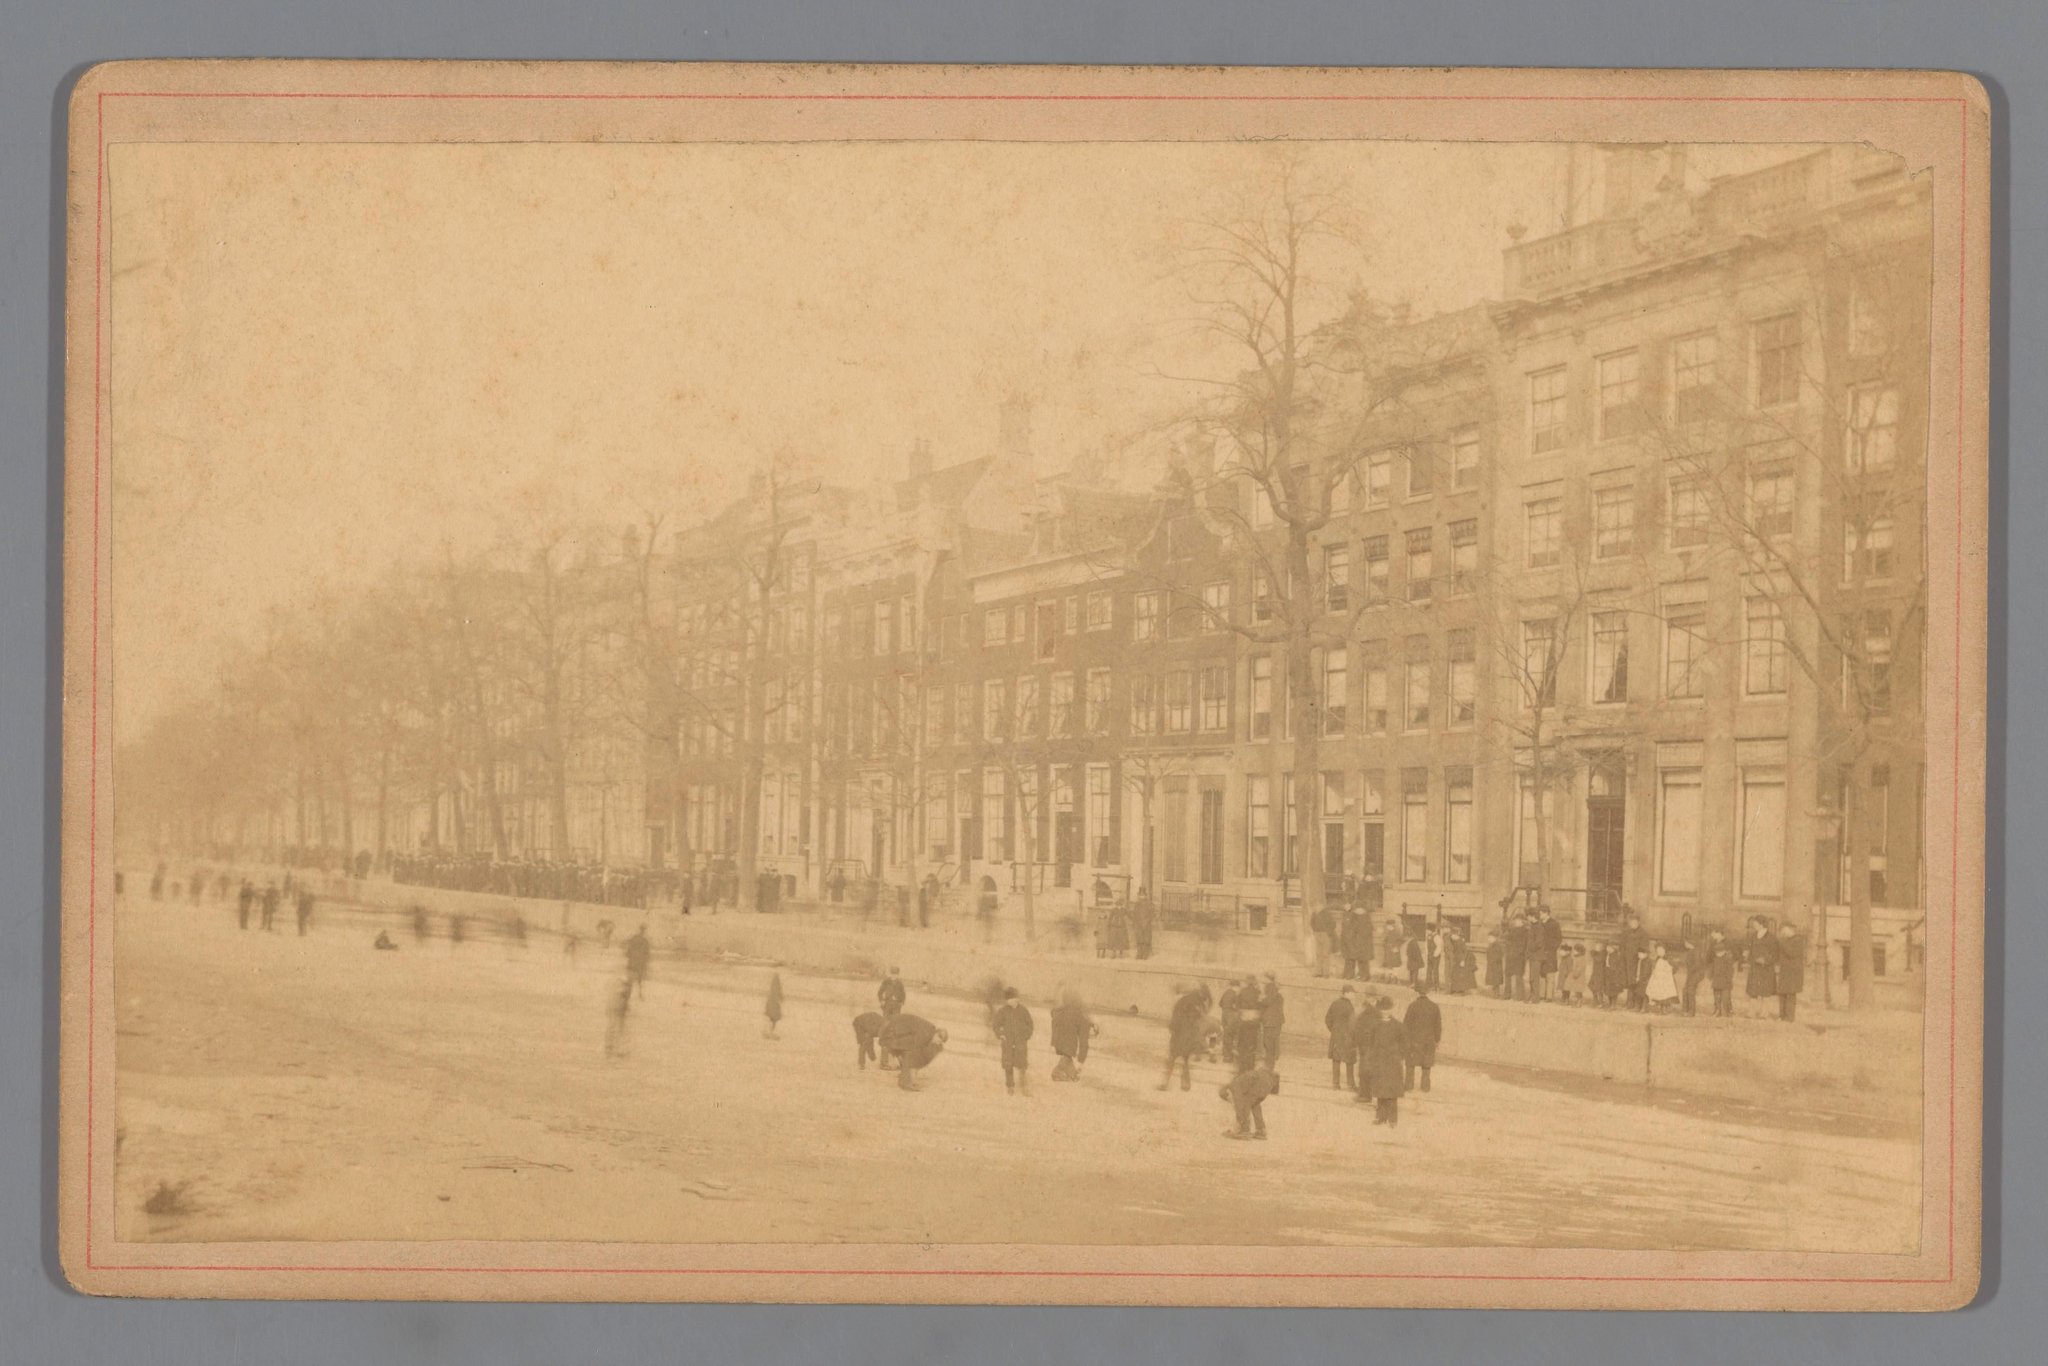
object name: photograph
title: Schaatsende personen op de Keizersgracht in Amsterdam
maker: Anonymous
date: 1850-1900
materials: cardboard, photographic support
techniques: albumen print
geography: amsterdam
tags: skates (winter sports), canals, waters (in city)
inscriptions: annotation: ‘Amsterdam/ keizersgr. oneven zijde/ voorbij Raadhuisstraat t/m 221’